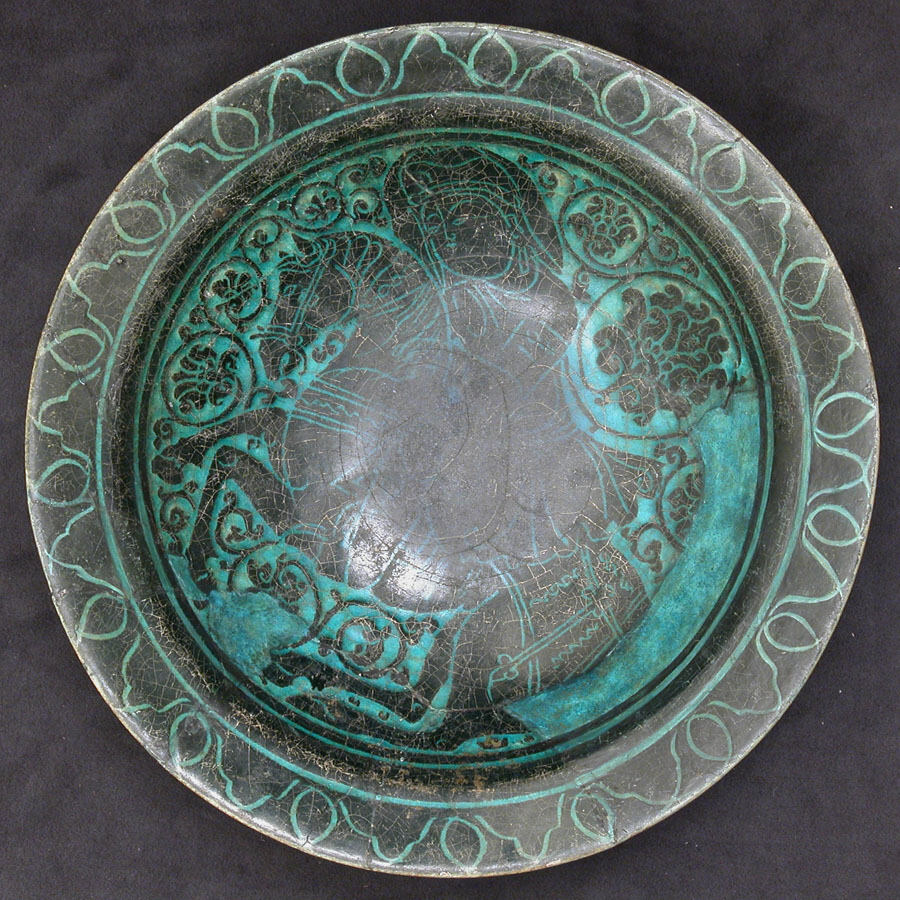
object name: dish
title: Dish with Horse and Rider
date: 1201-1300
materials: glaze, stonepaste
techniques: incising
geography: iran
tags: horses